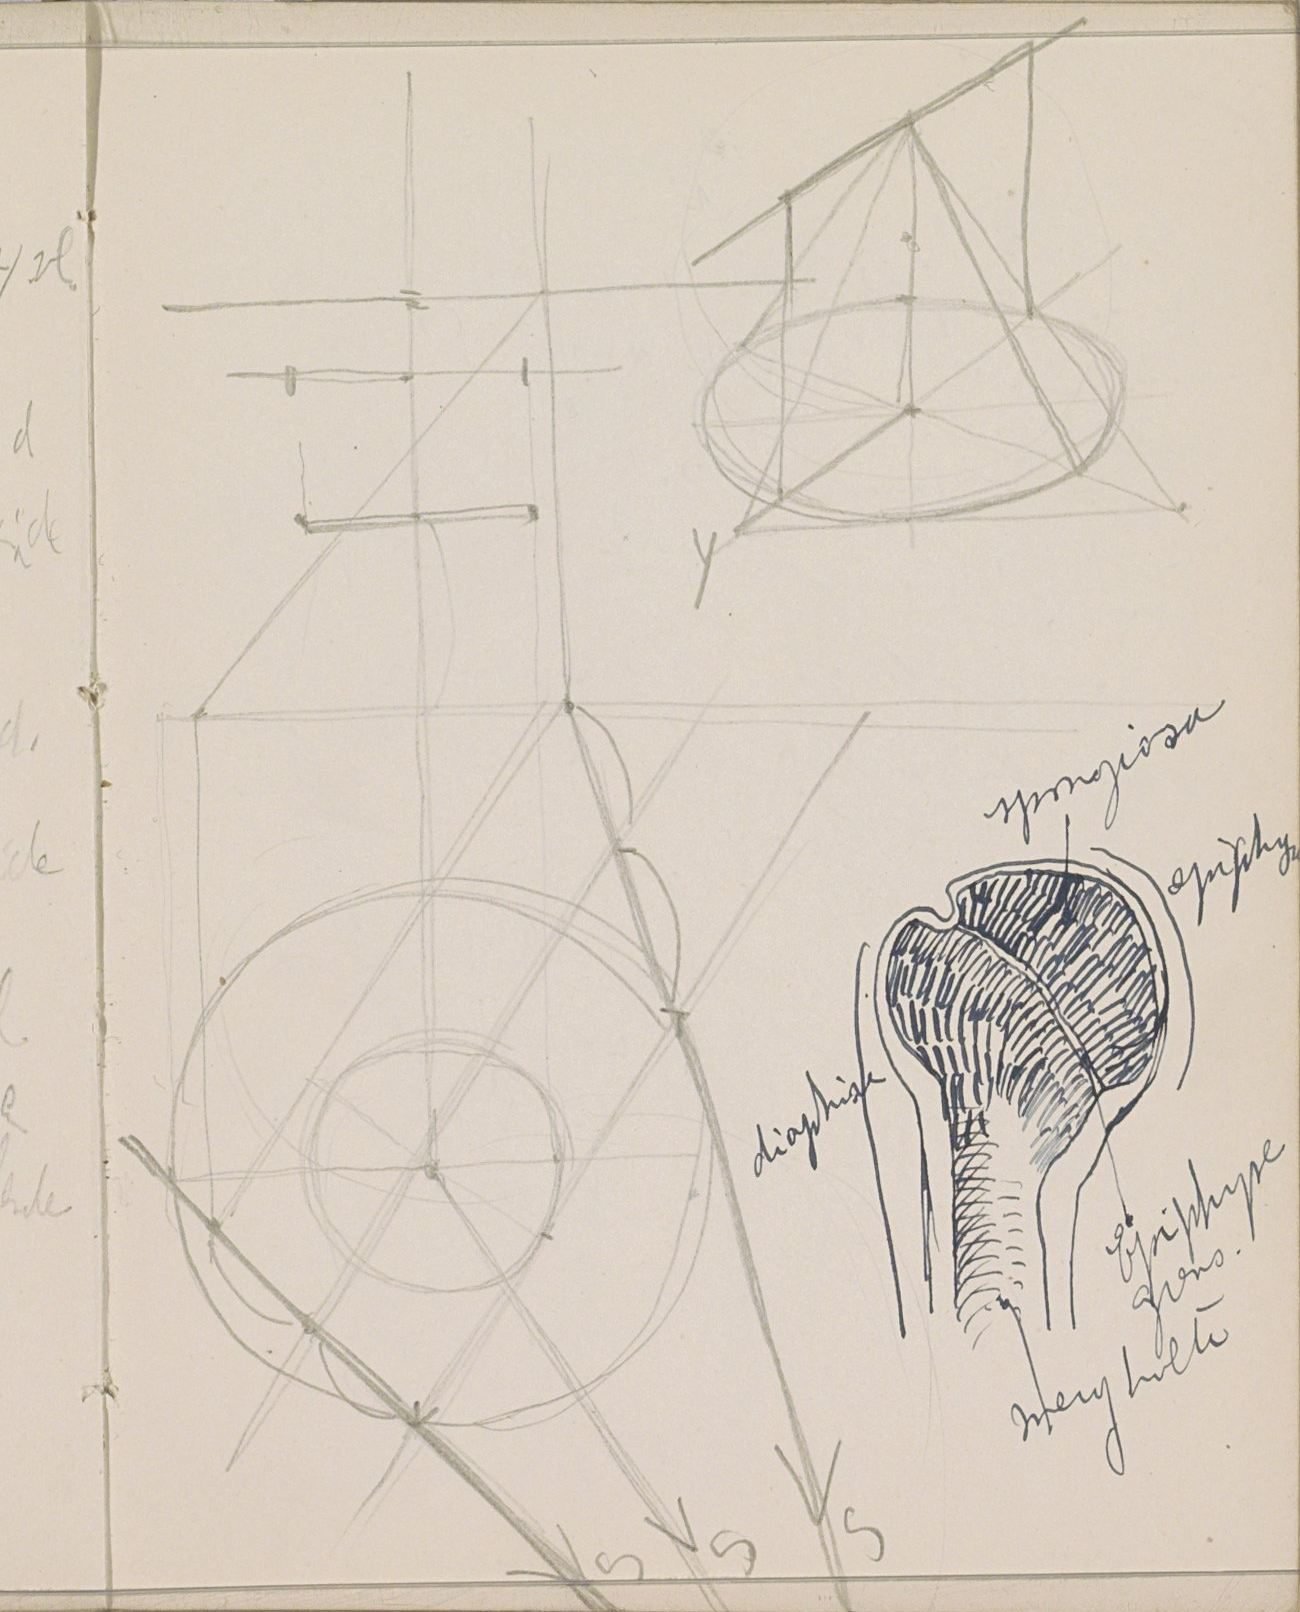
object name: sketchbook leaf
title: Ronde uiteinde van een bot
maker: reijer stolk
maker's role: draughtsman, print maker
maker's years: 1896-1945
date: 1916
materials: ink, paper, pencil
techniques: pen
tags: bones in general (human body)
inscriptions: annotation: ‘spongiosa/ diaphise/ epiphyse/ epiphyse/ gres/ mergholte/ S S S’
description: Tevens ontwerpen of wiskundige modellen. Blad 25 recto uit een schetsboek met 72 bladen.